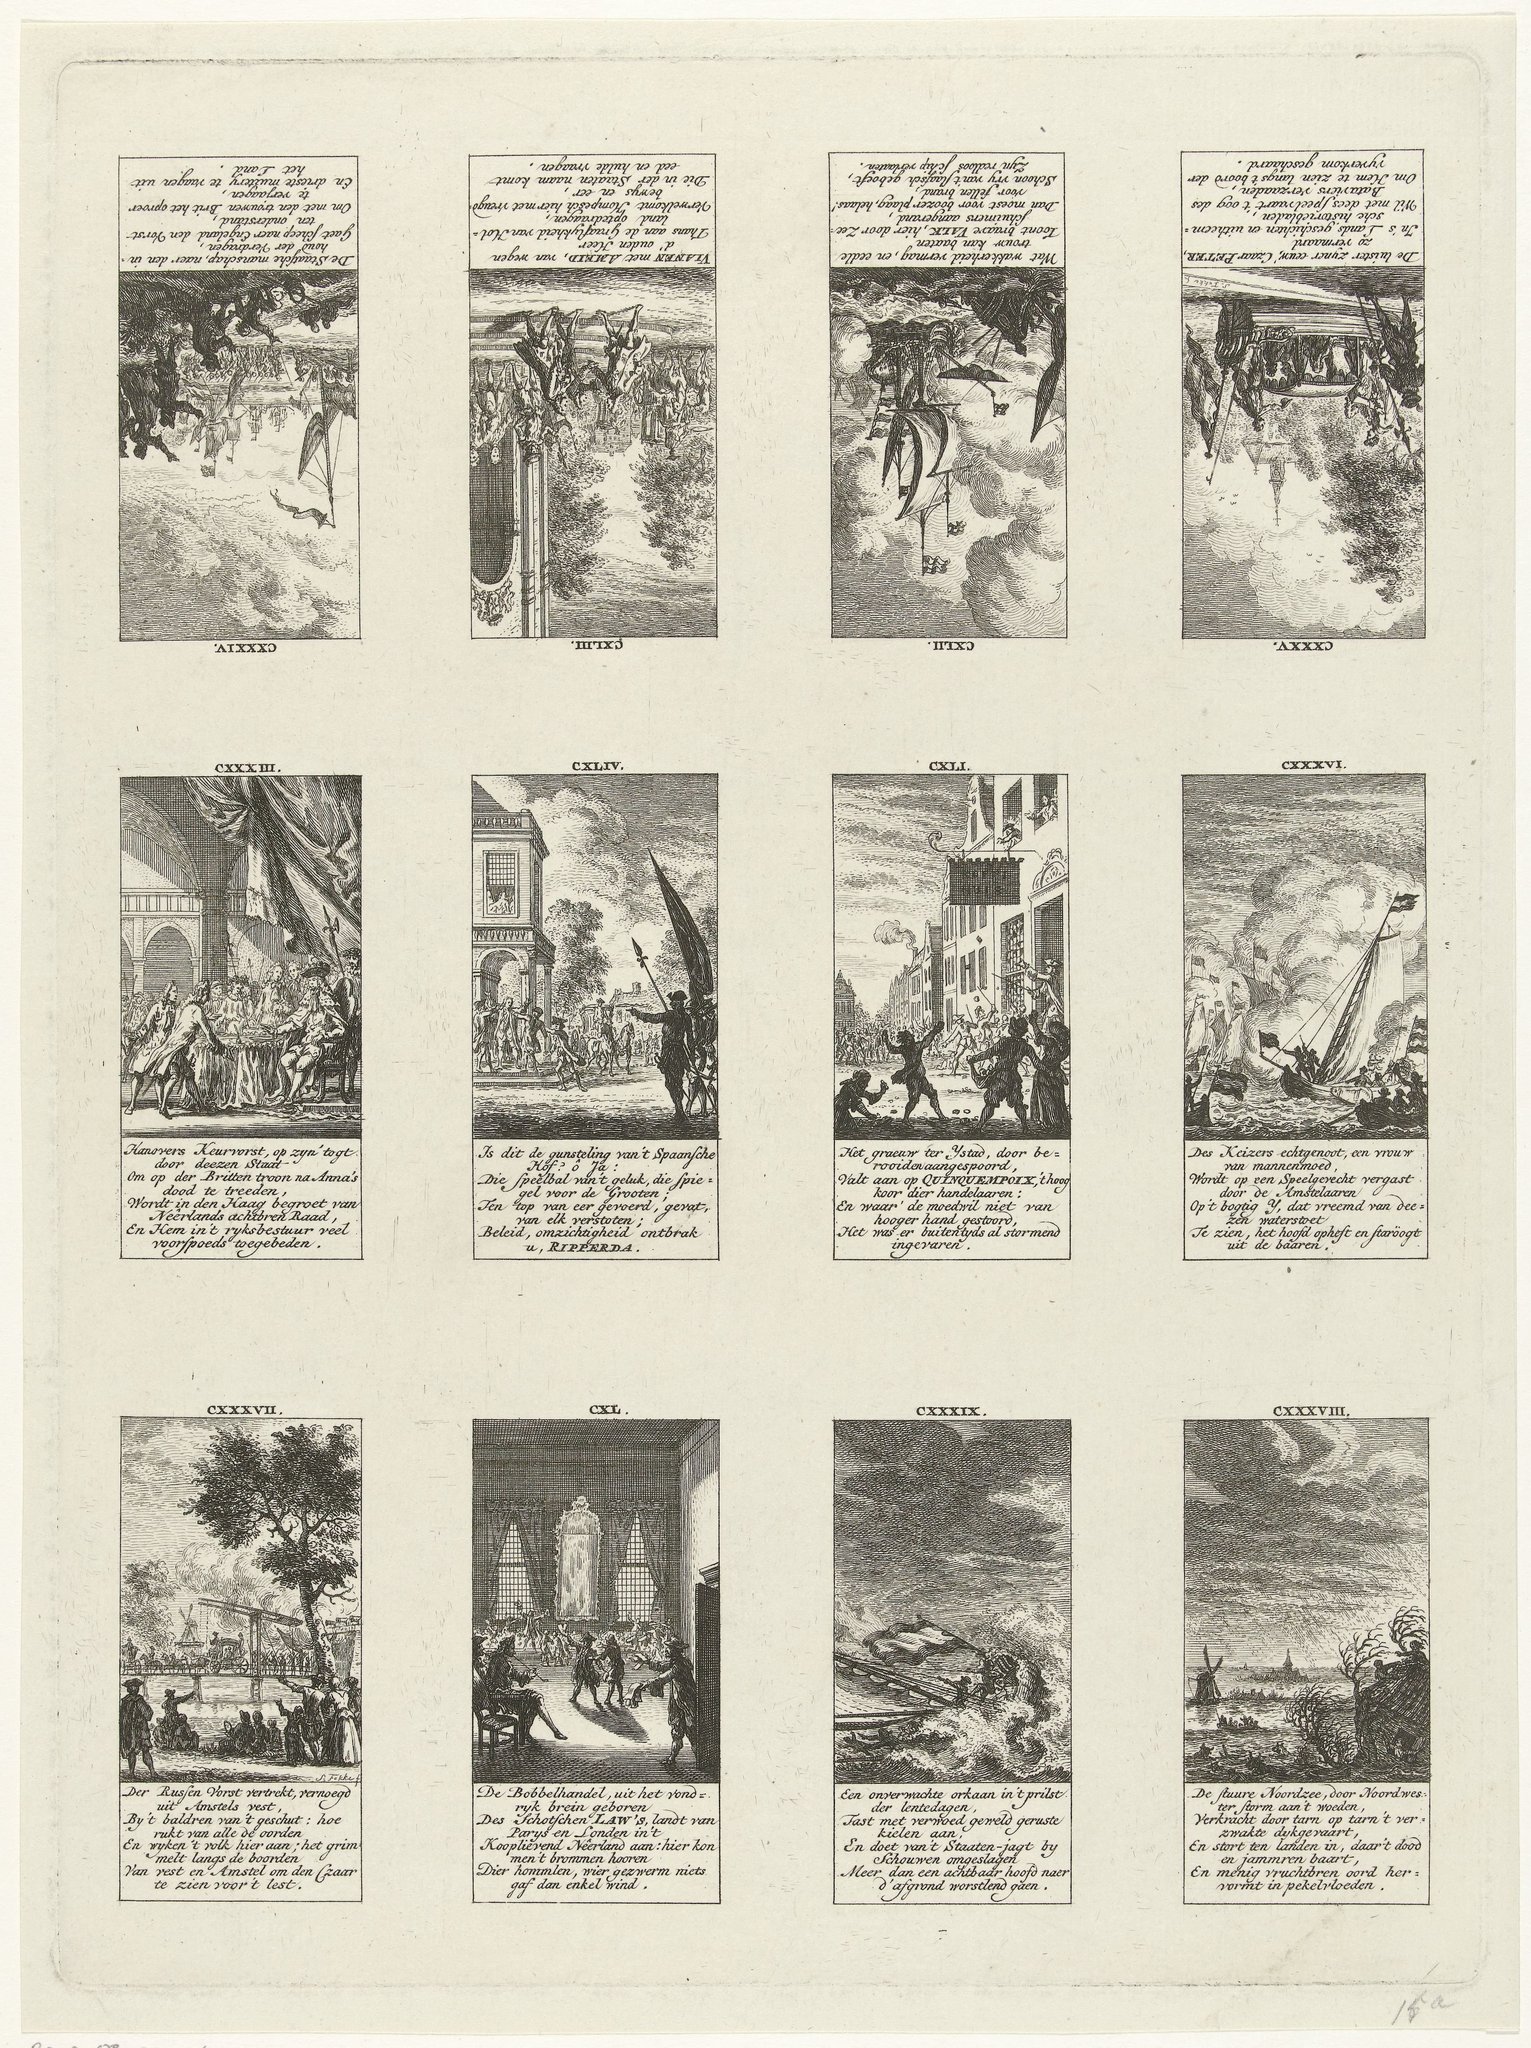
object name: print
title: Illustraties vaderlandse geschiedenis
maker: simon fokke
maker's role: draughtsman, print maker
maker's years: 1712-1784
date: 1722-1784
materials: paper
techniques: etching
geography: amsterdam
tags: historical events and situations, historical persons (portraits and scenes from the life)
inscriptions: collector's mark: Lugt 2228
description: Onversneden blad met twaalf voorstellingen uit de vaderlandse geschiedenis. De afbeeldingen zijn middenboven genummerd van CXXXIII tot en met CXLIV en voorzien van toelichtende onderschriften.